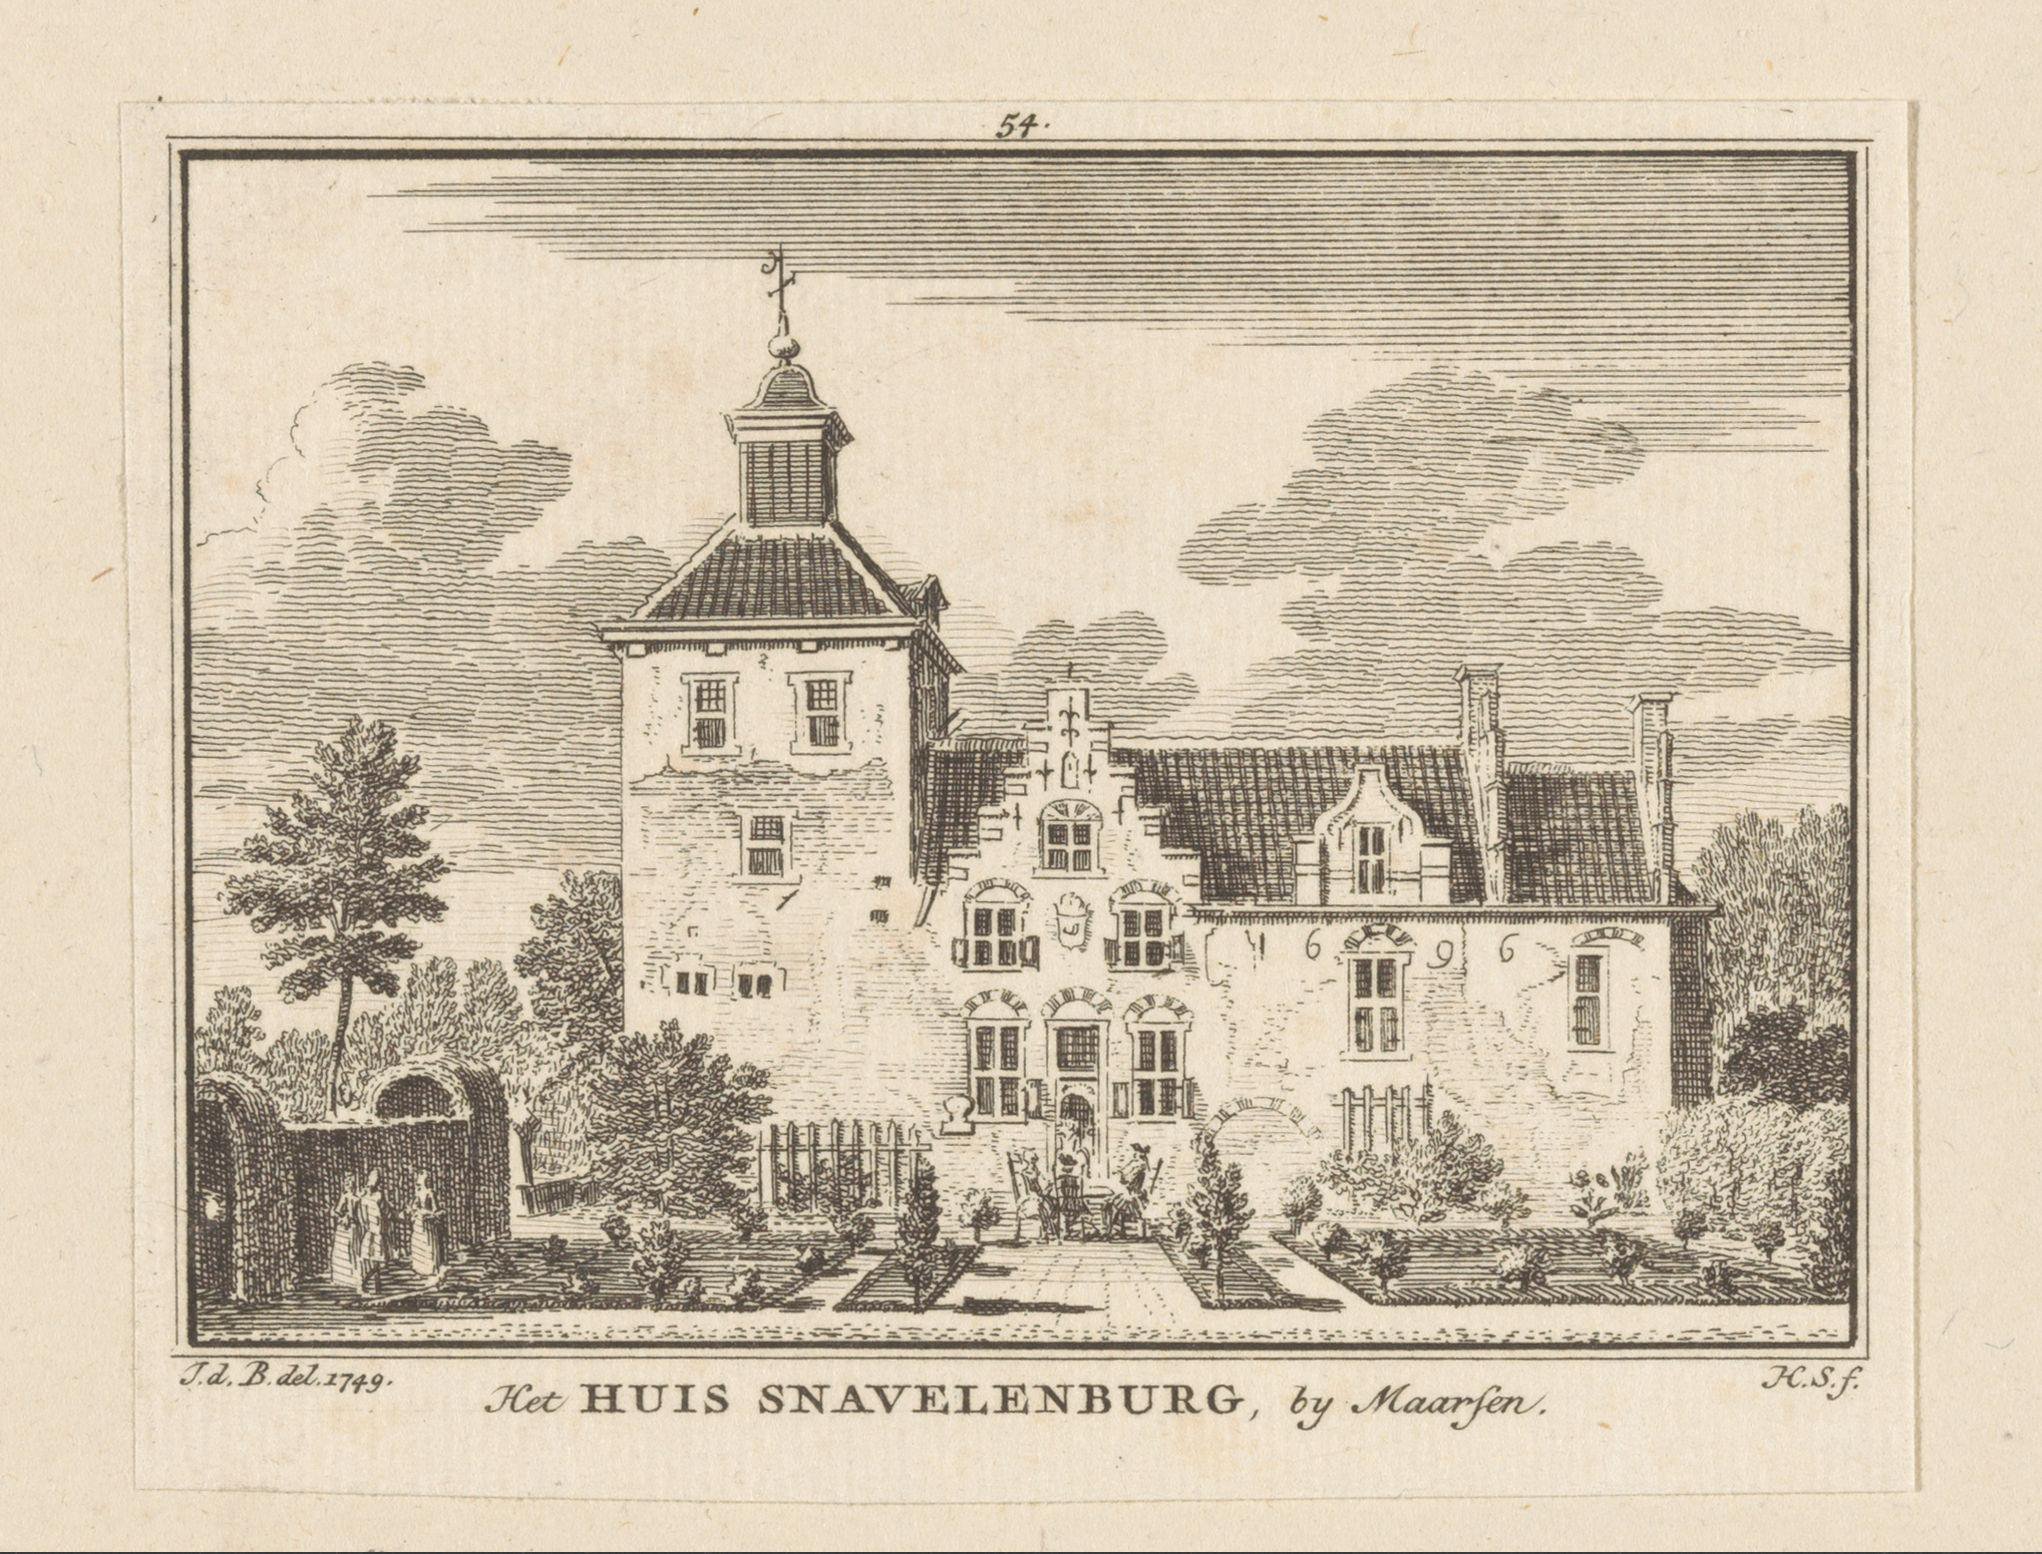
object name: book illustration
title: Het huis Snavelenburg, by Maarsen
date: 1773-1792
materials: paper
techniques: engraving, etching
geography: haarlem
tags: castle, french or architectonic garden; formal garden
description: Prent ook gebruikt in: Het verheerlykt Nederland of kabinet van hedendaagsche gezigten van steden, dorpen (…). 9 delen. Amsterdam: Isaak Tirion en weduwe Isaak Tirion, 1745-1774, dl. 7, 8 of 9 (weduwe Isaak Tirion, 1773-1774), ill. 54. Of in: Nederlandsche tafereelen; of eene keurige verzameling van negen honderd fraaije gezigten van steden, dorpen, sloten, oudheden (….). 9 delen. Amsterdam: Jan de Groot, 1792, dl. 7, 8 of 9, ill. 54. Uit welke druk het huidige exemplaar precies komt is niet na te gaan.